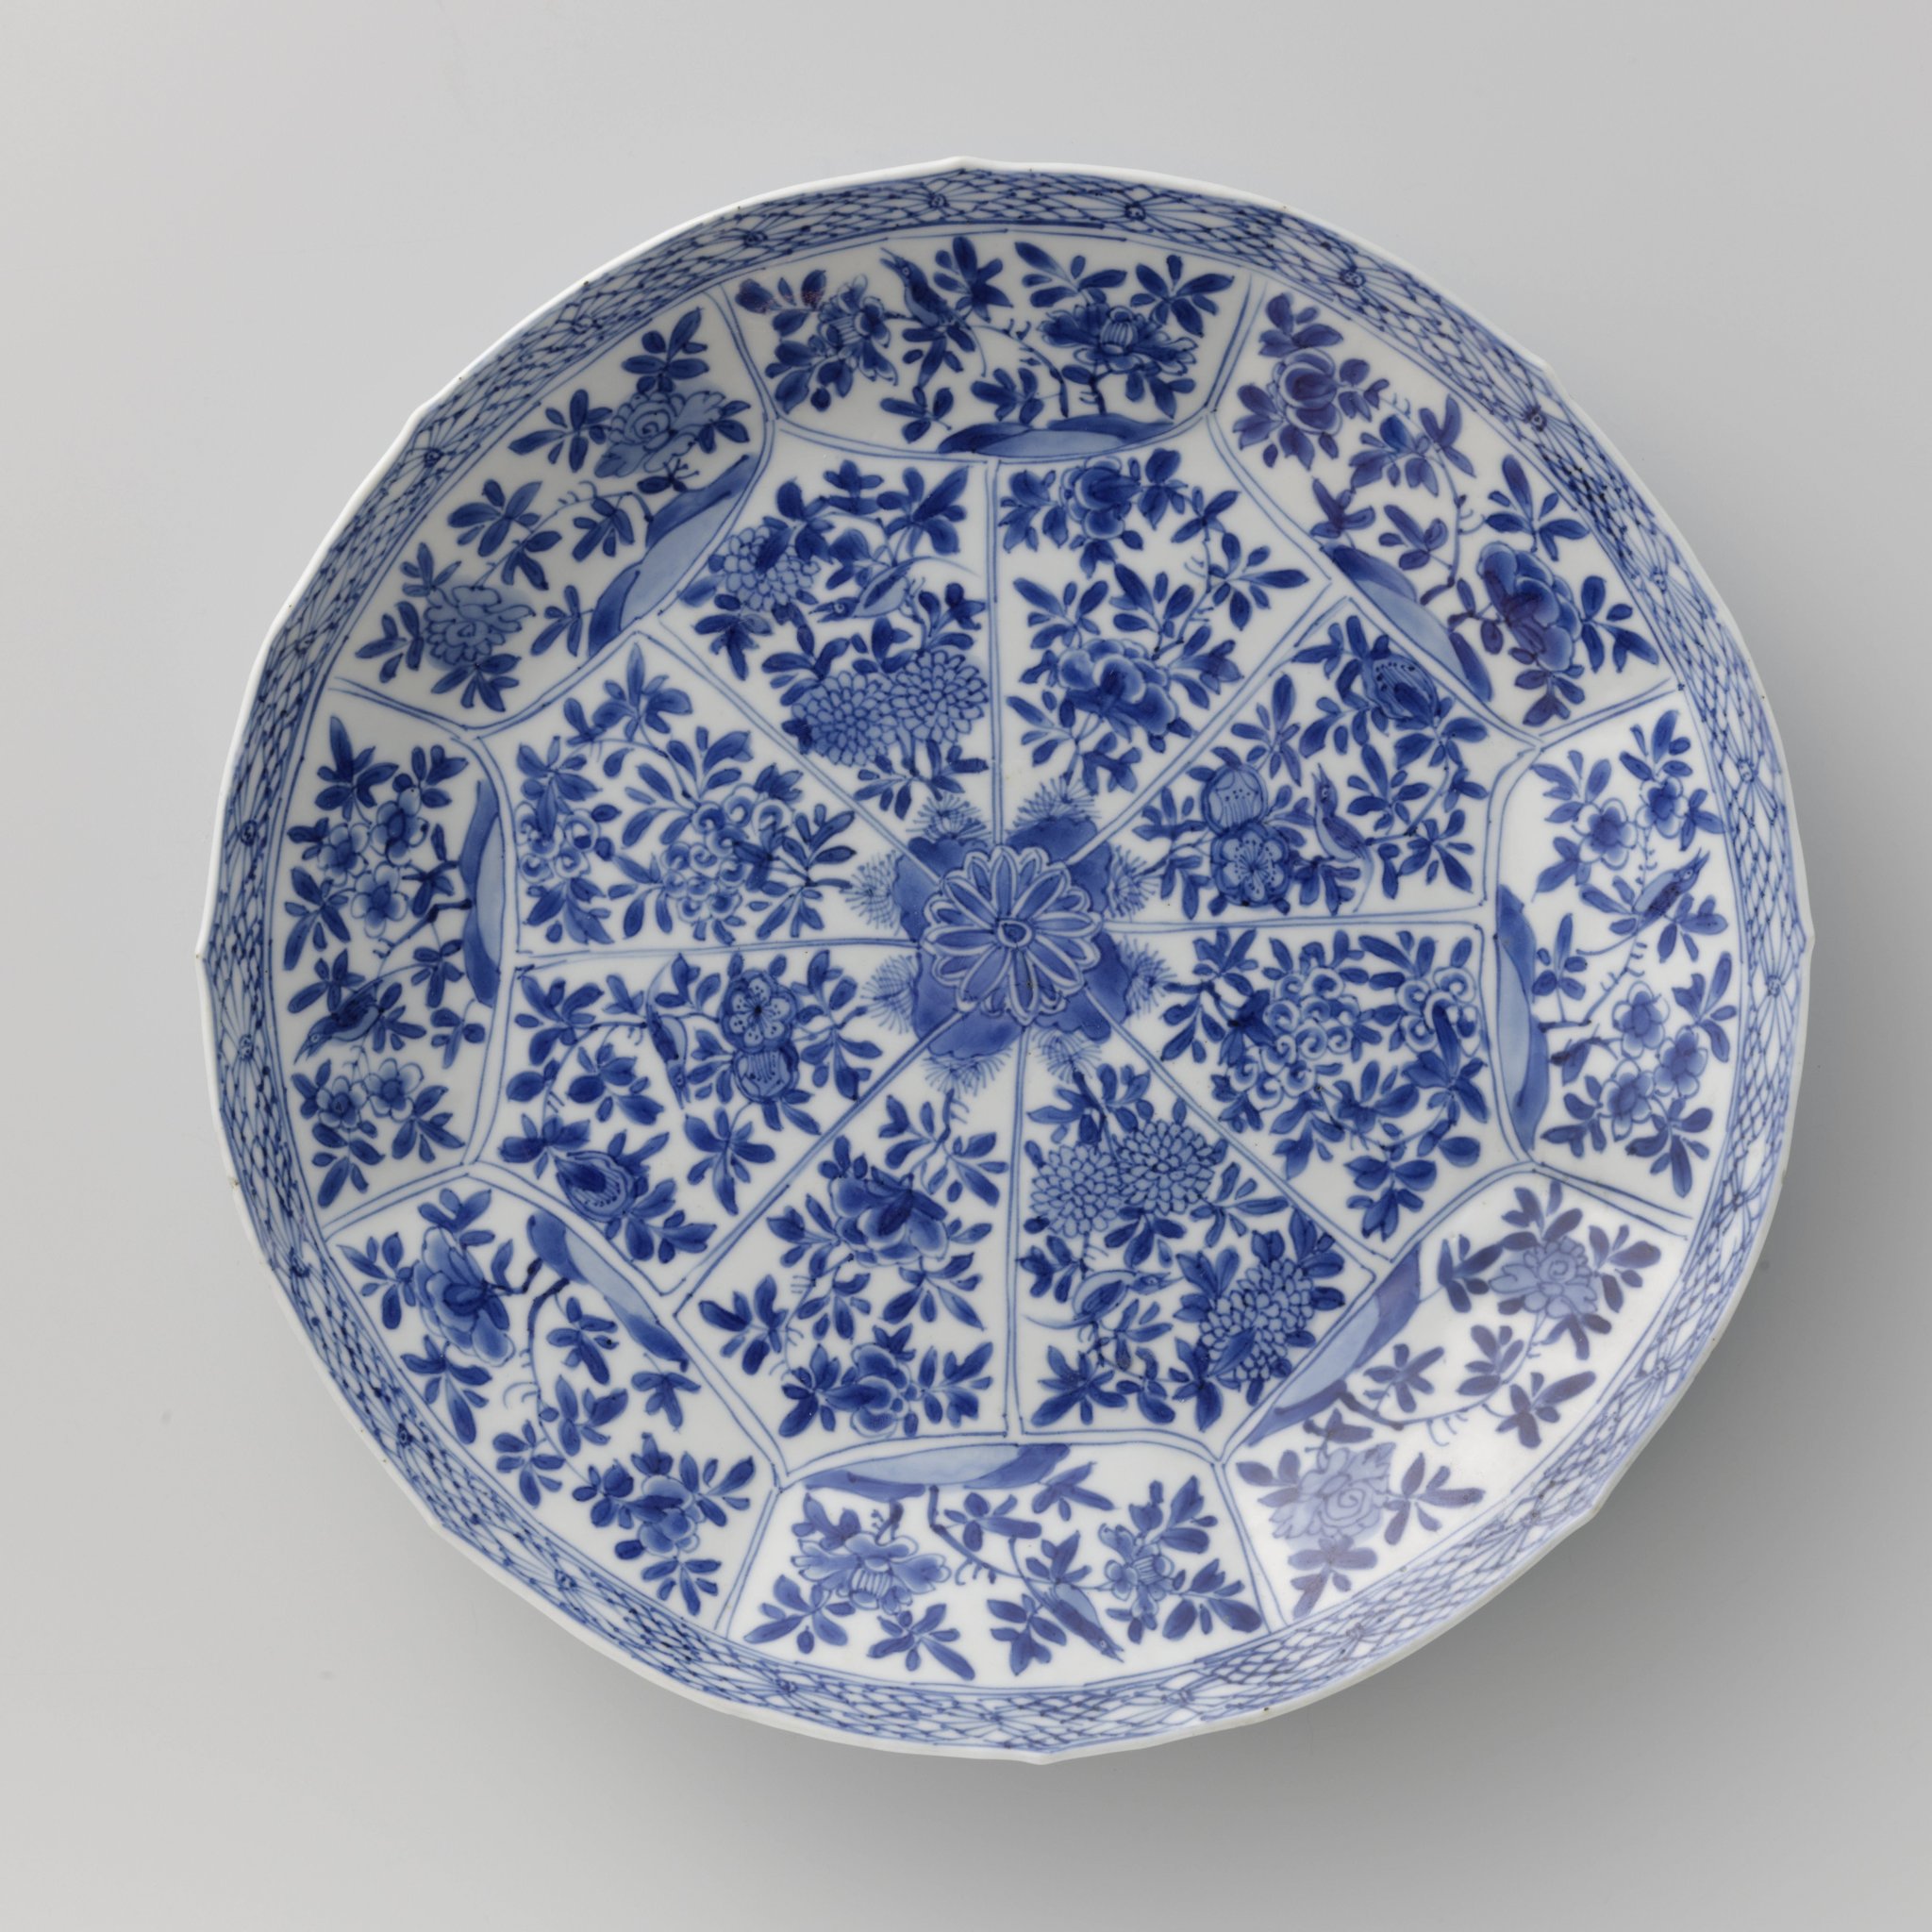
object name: dish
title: Saucer-dish with panel decoration with flower sprays and birds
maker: Anonymous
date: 1680-1720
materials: cobalt, glaze, paint, porcelain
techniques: firing, forming, turning, vitrification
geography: china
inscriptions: mark